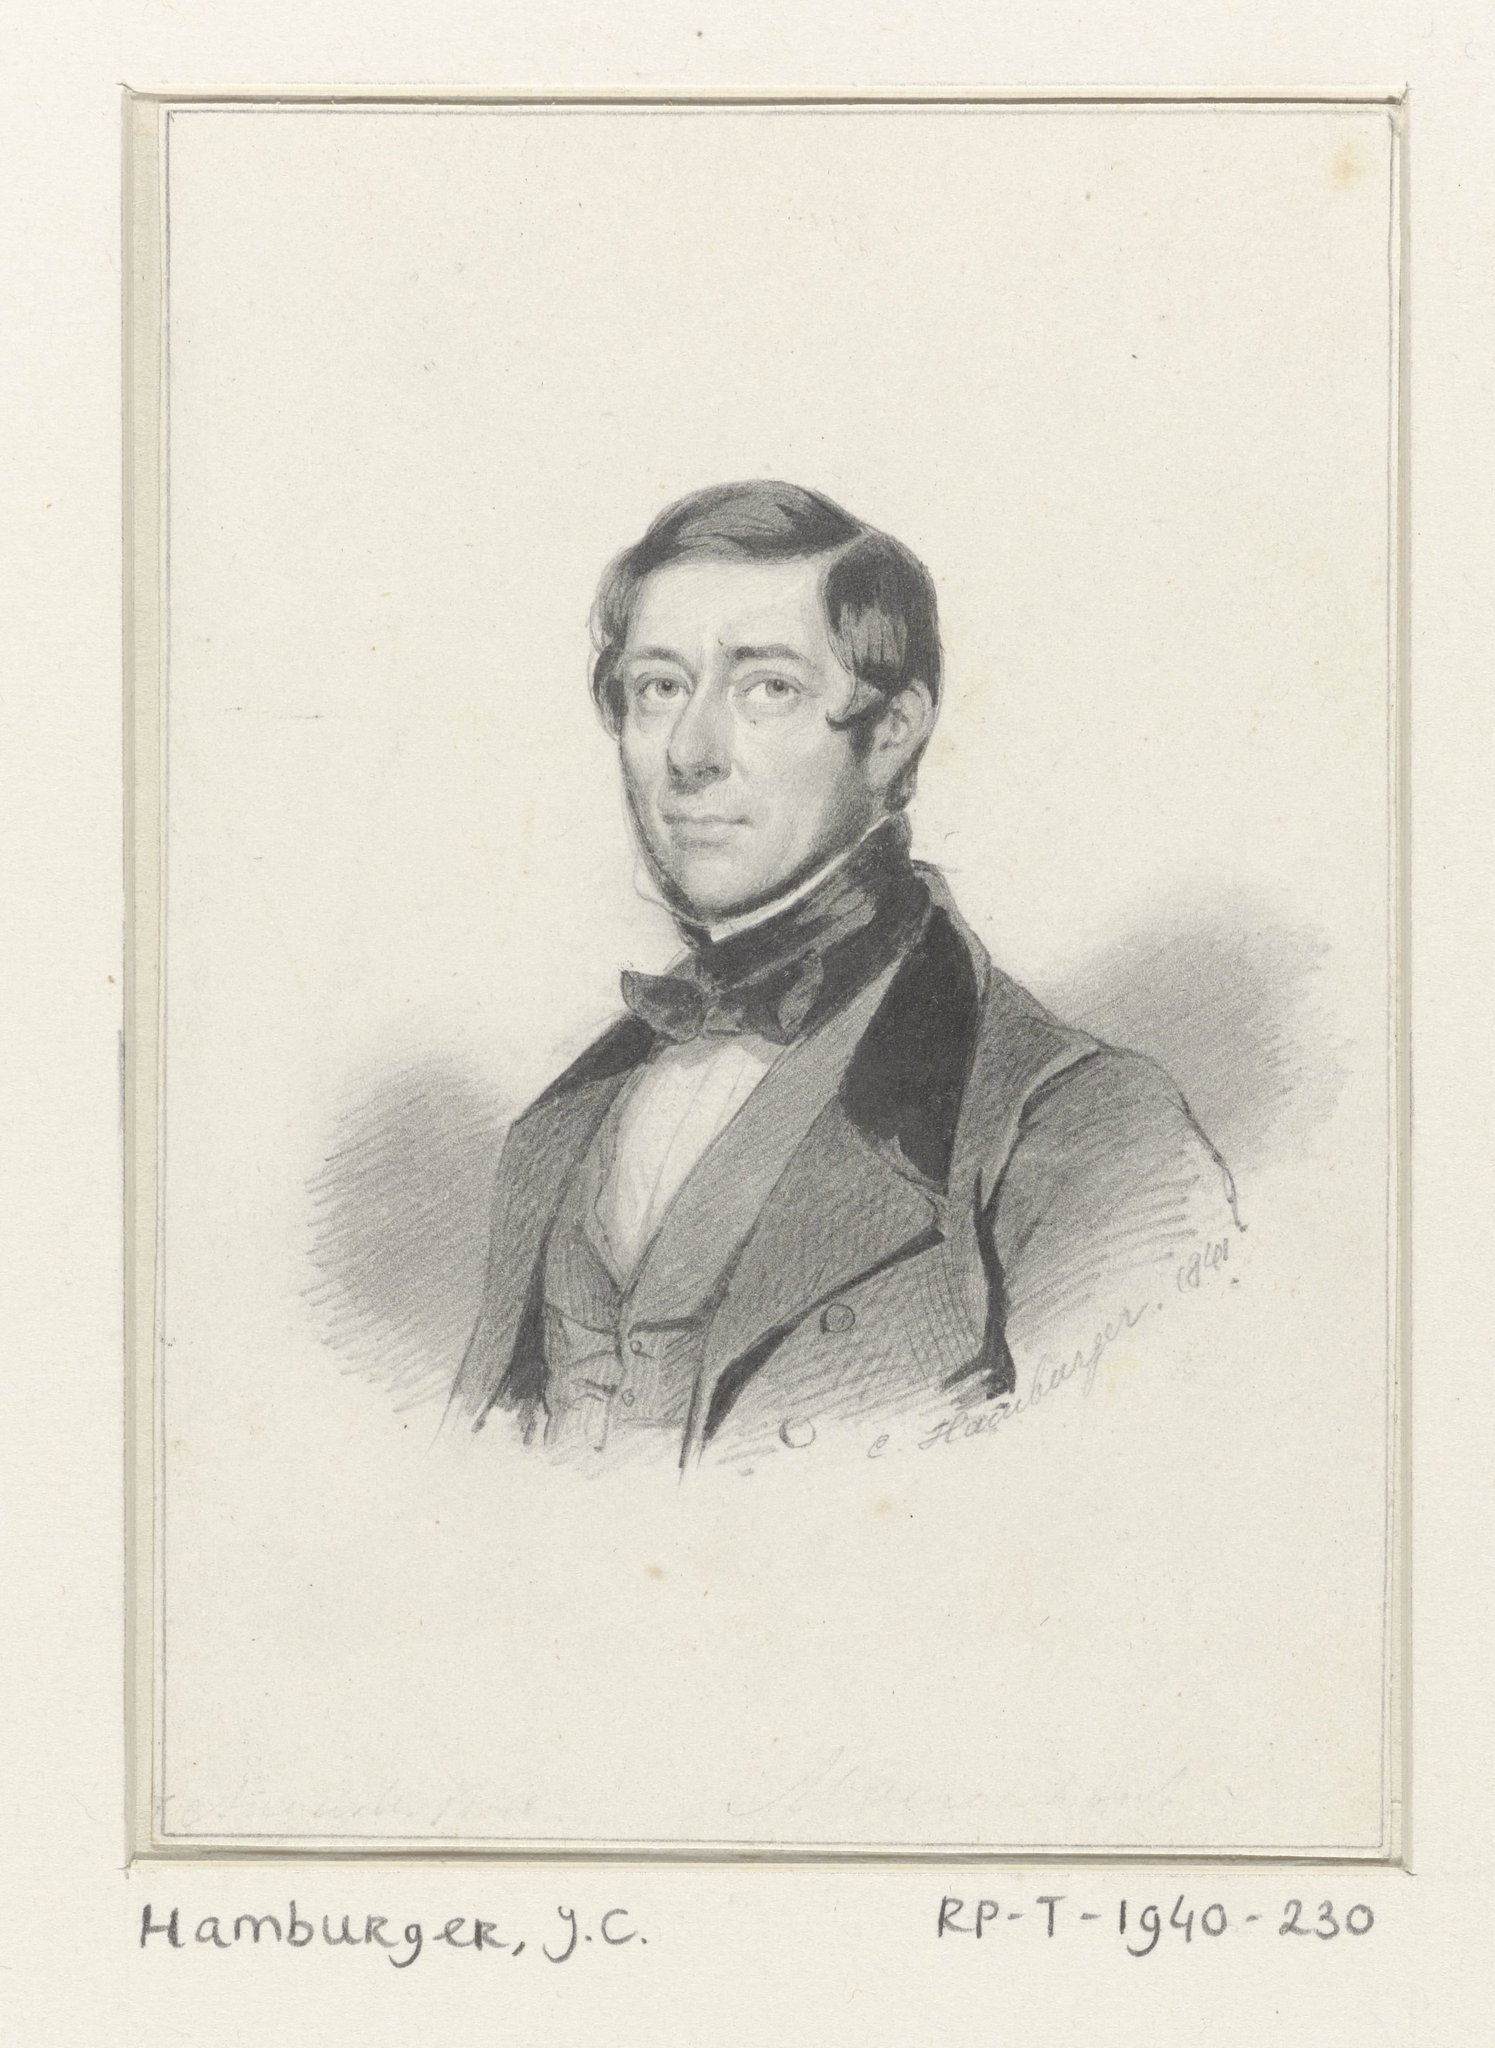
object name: drawing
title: Portret van Josephus Jodocus Moerenhout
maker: coenraad hamburger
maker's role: draughtsman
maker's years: 1809-1891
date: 1841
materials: paper, pencil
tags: antwerp, joseph moerenhout, historical persons, portrait, self-portrait of artist